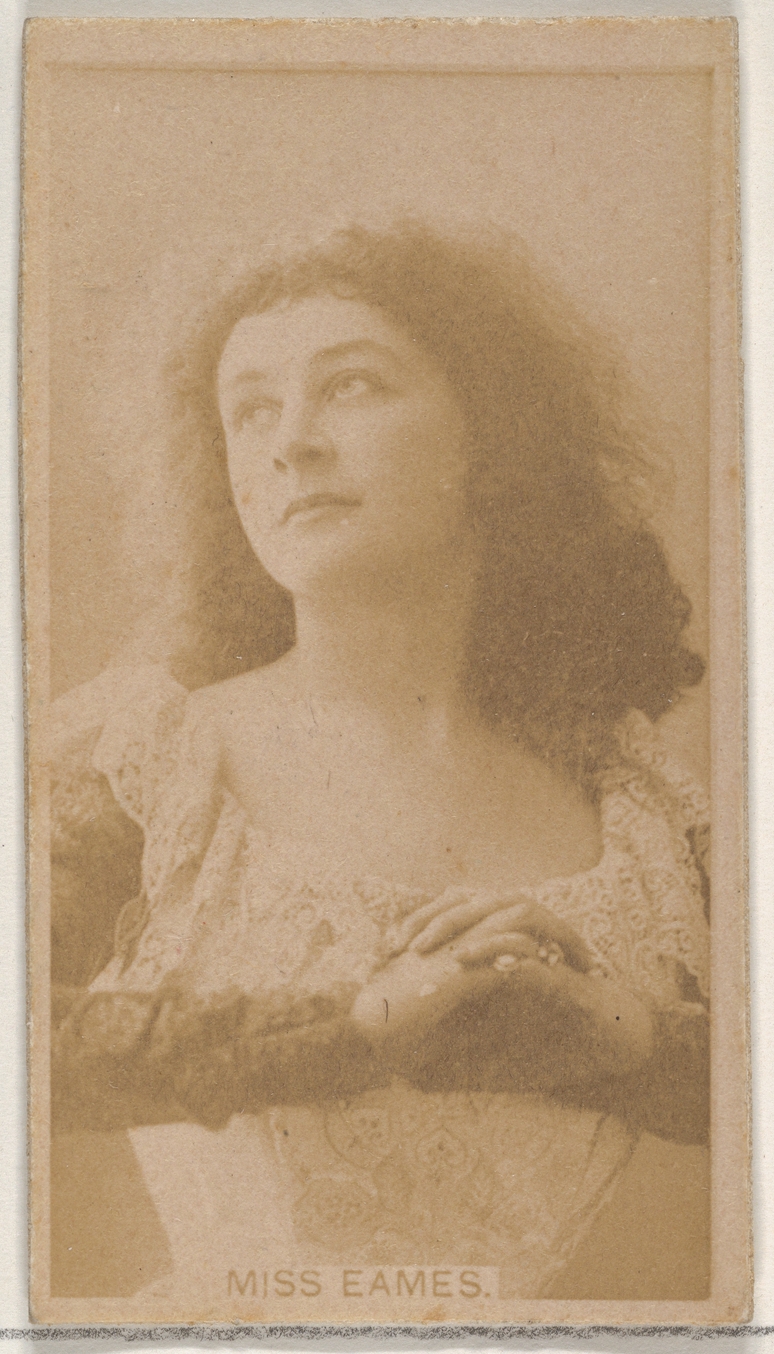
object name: photograph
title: Miss Eames, from the Actors and Actresses series (N45, Type 8) for Virginia Brights Cigarettes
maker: allen & ginter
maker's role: publisher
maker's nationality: american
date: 1888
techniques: albumen silver print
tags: portraits,women,actresses